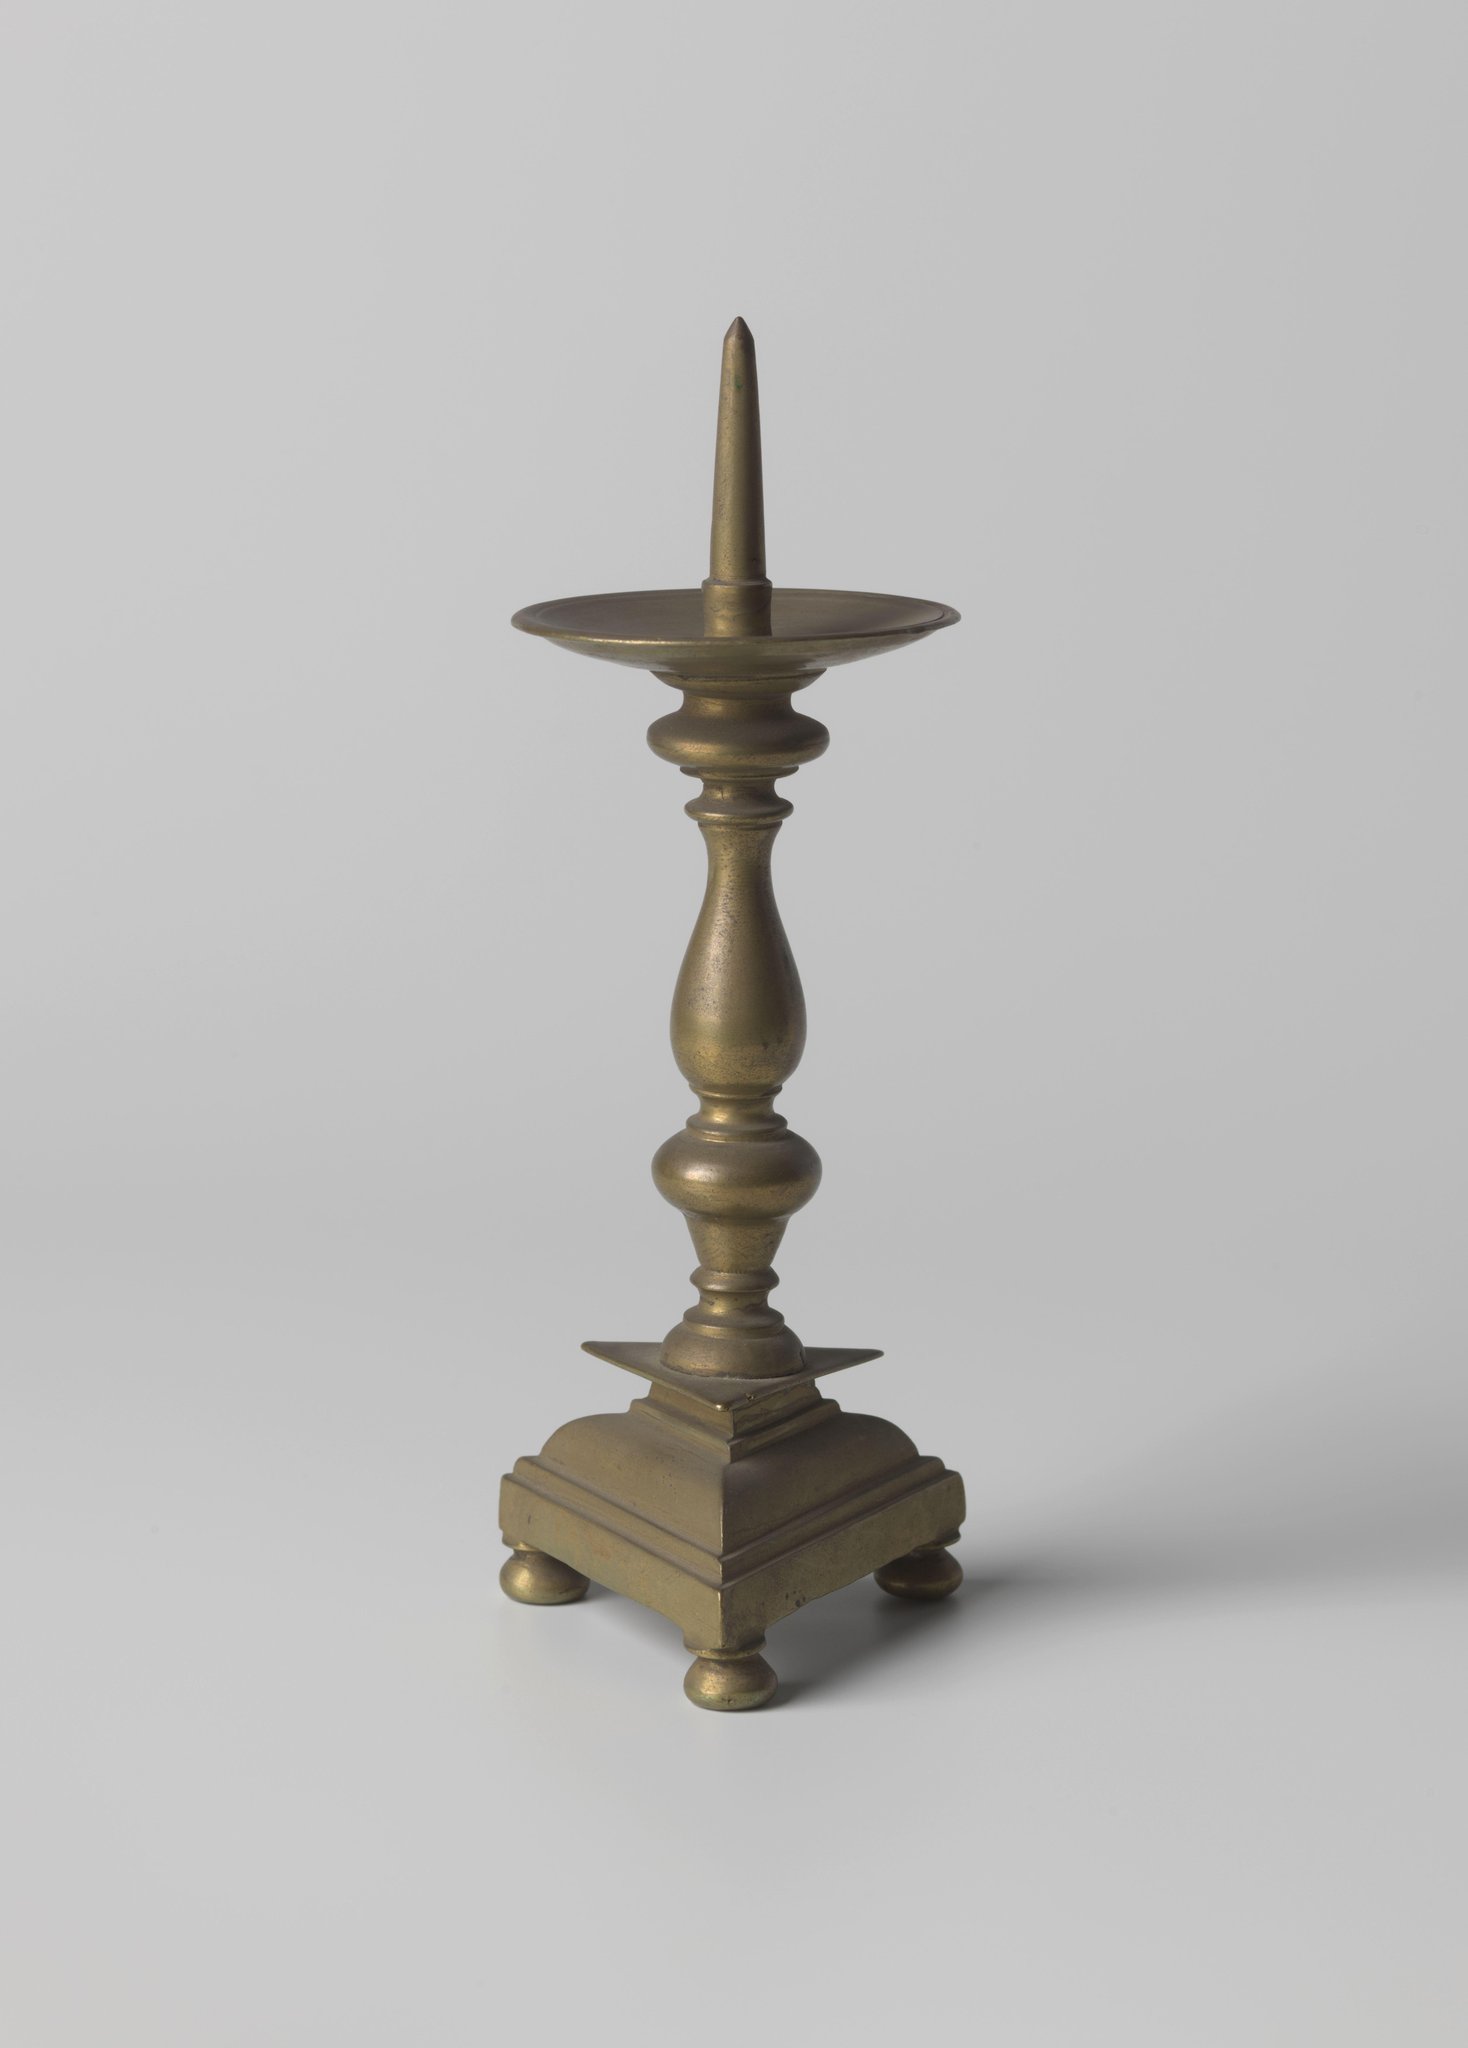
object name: candlestick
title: Kandelaar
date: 1400-1950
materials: brass, copper